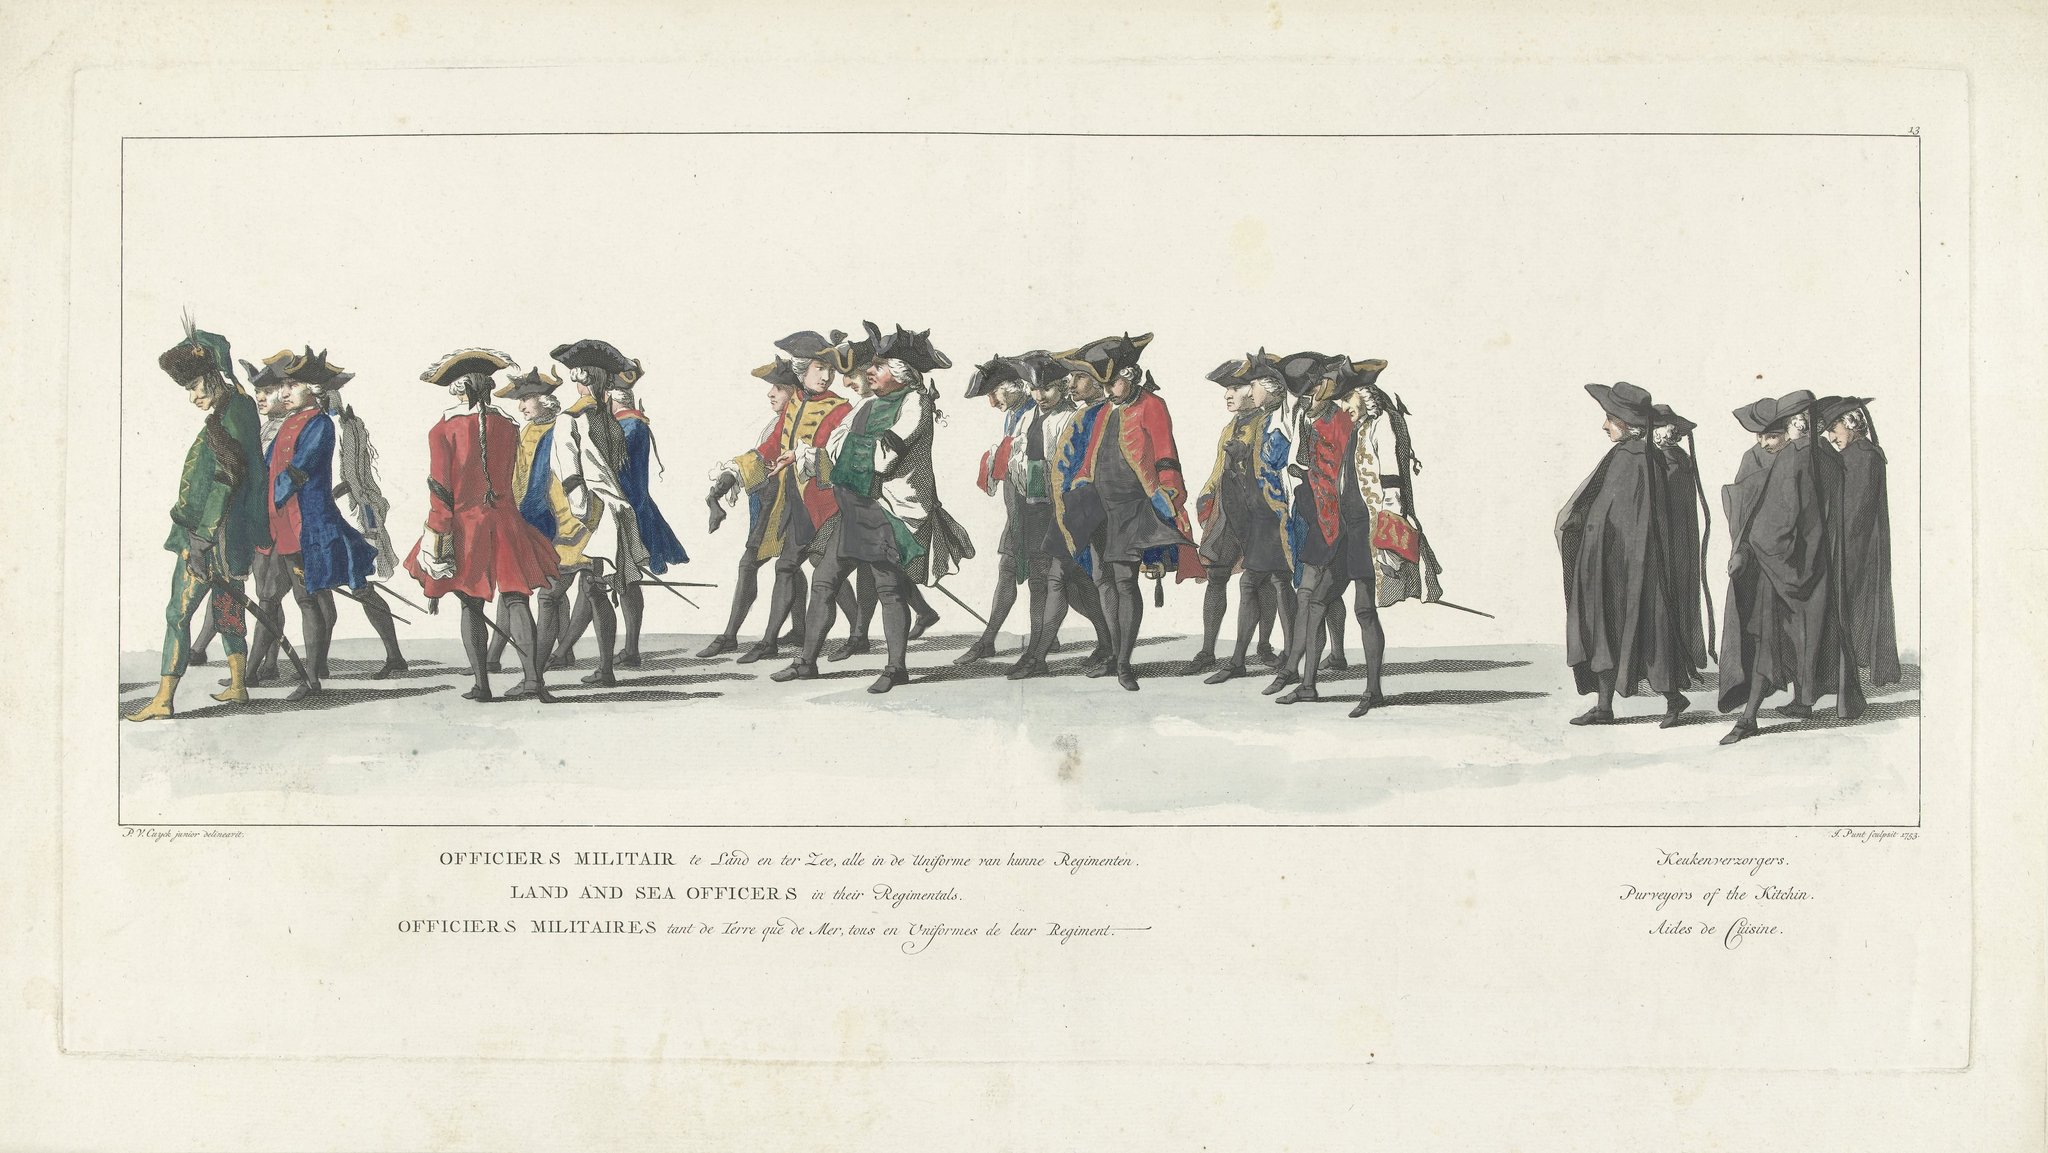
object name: print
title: Officiers Militair te Land en ter Zee, alle in de Uniforme van hunne Regimenten / Keukenverzorgers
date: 1752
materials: paper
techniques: engraving, etching, hand coloring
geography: northern netherlands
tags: willem iv (prins van oranje-nassau), cortege, funeral procession, military parade, pageant, delft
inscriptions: collector's mark: Lugt 2228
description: Militaire officieren en keukenverzorgers. In de marge het onderschrift in Nederlands, Frans en Engels. Onderdeel van een serie van 41 platen van de begrafenisstoet van stadhouder Willem IV te Delft op 4 februari 1752. Genummerd rechtsboven: 13.